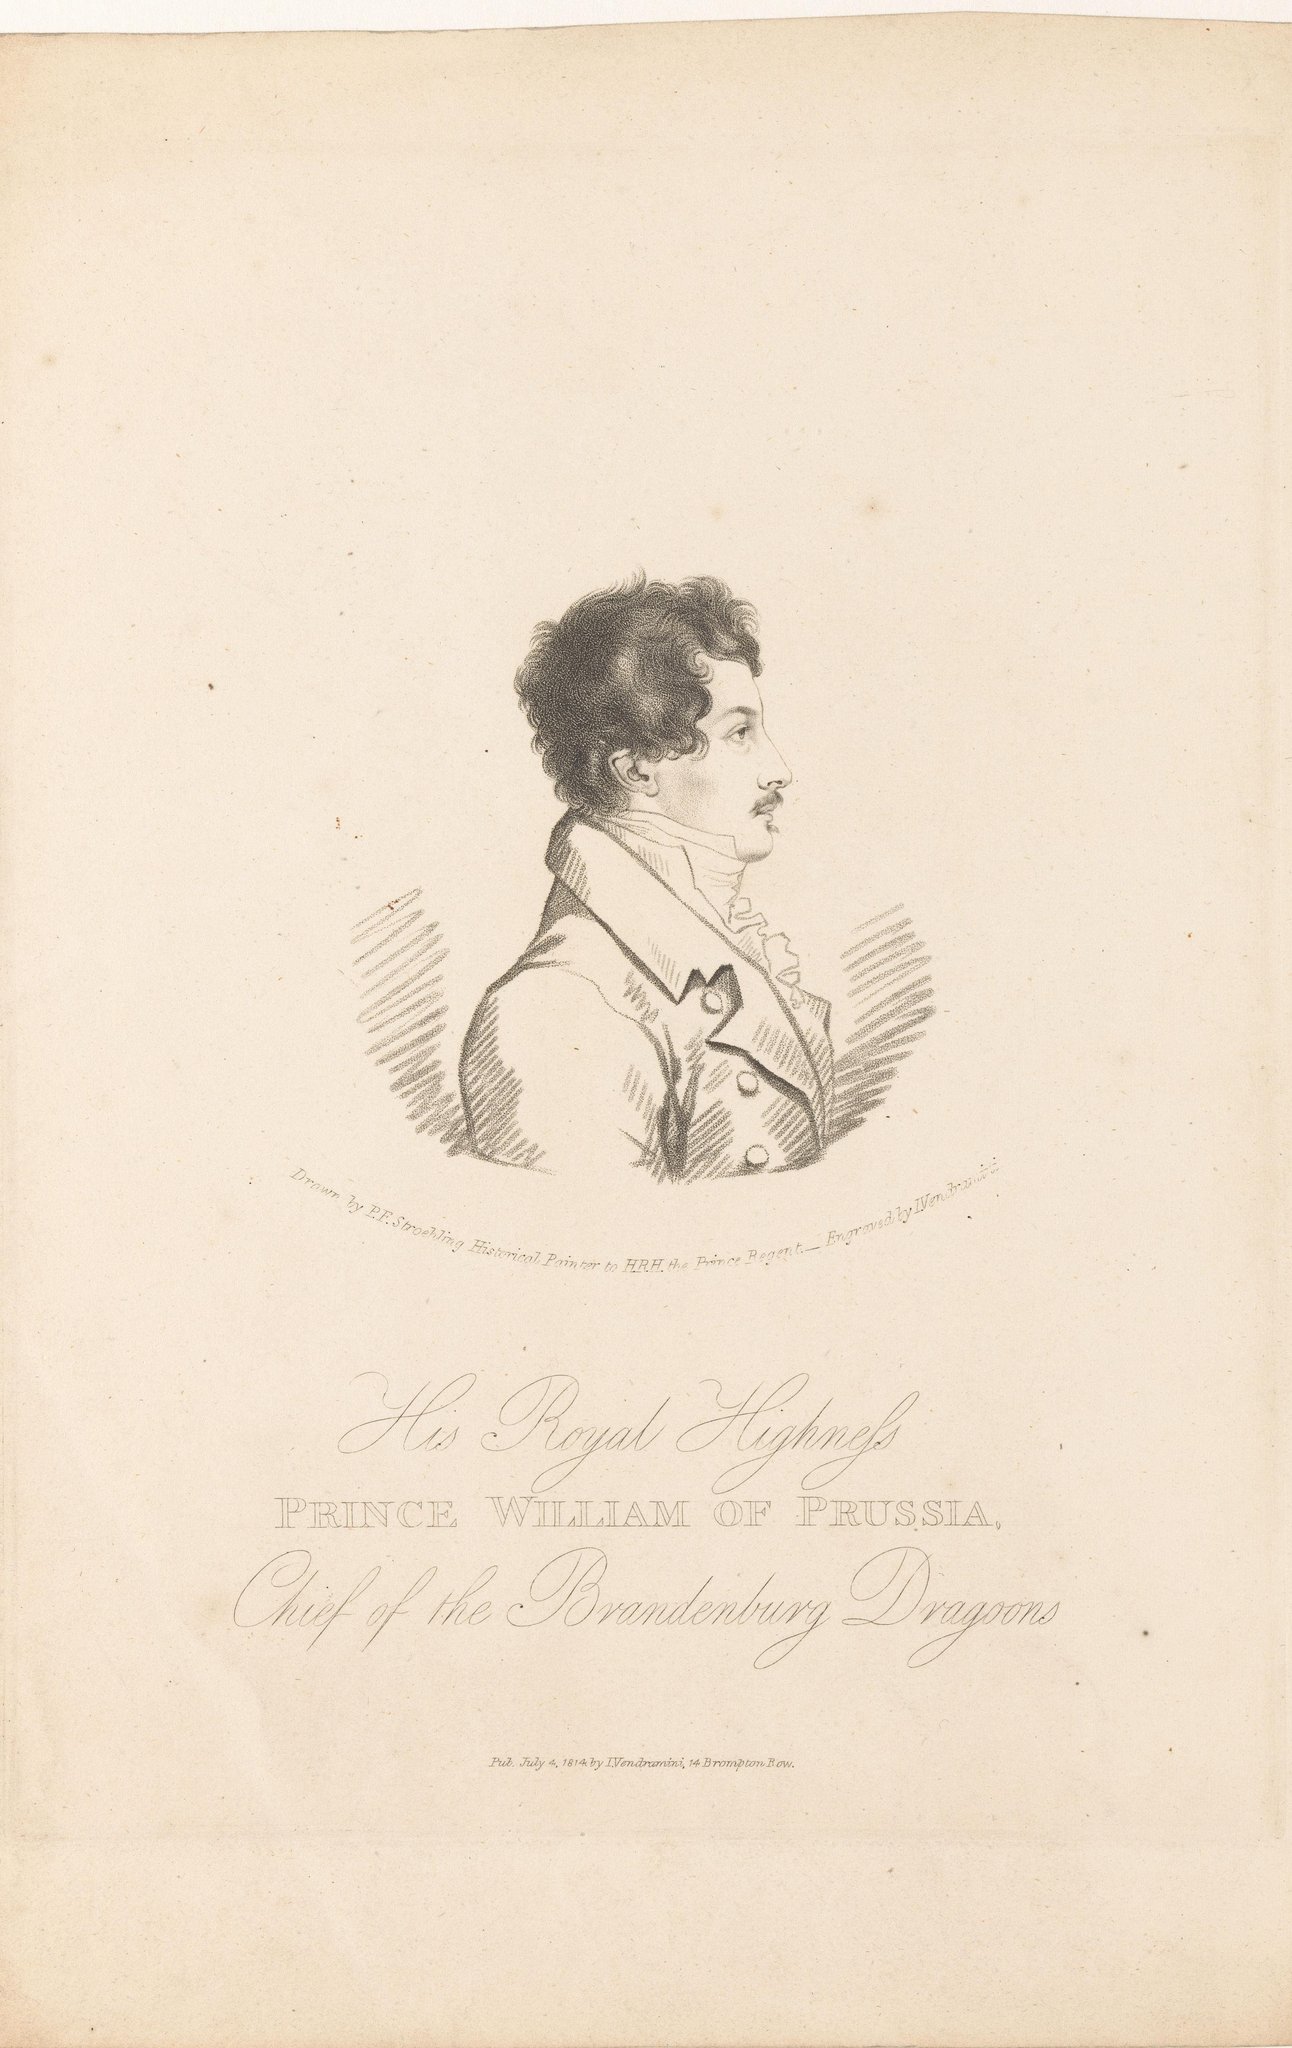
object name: print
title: Portret van Frederik Willem IV, koning van Pruisen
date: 1814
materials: paper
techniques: engraving, roulette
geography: london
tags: berlin, frederik willem iv (koning van pruisen), historical persons, ruler, sovereign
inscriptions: collector's mark: Lugt 2228